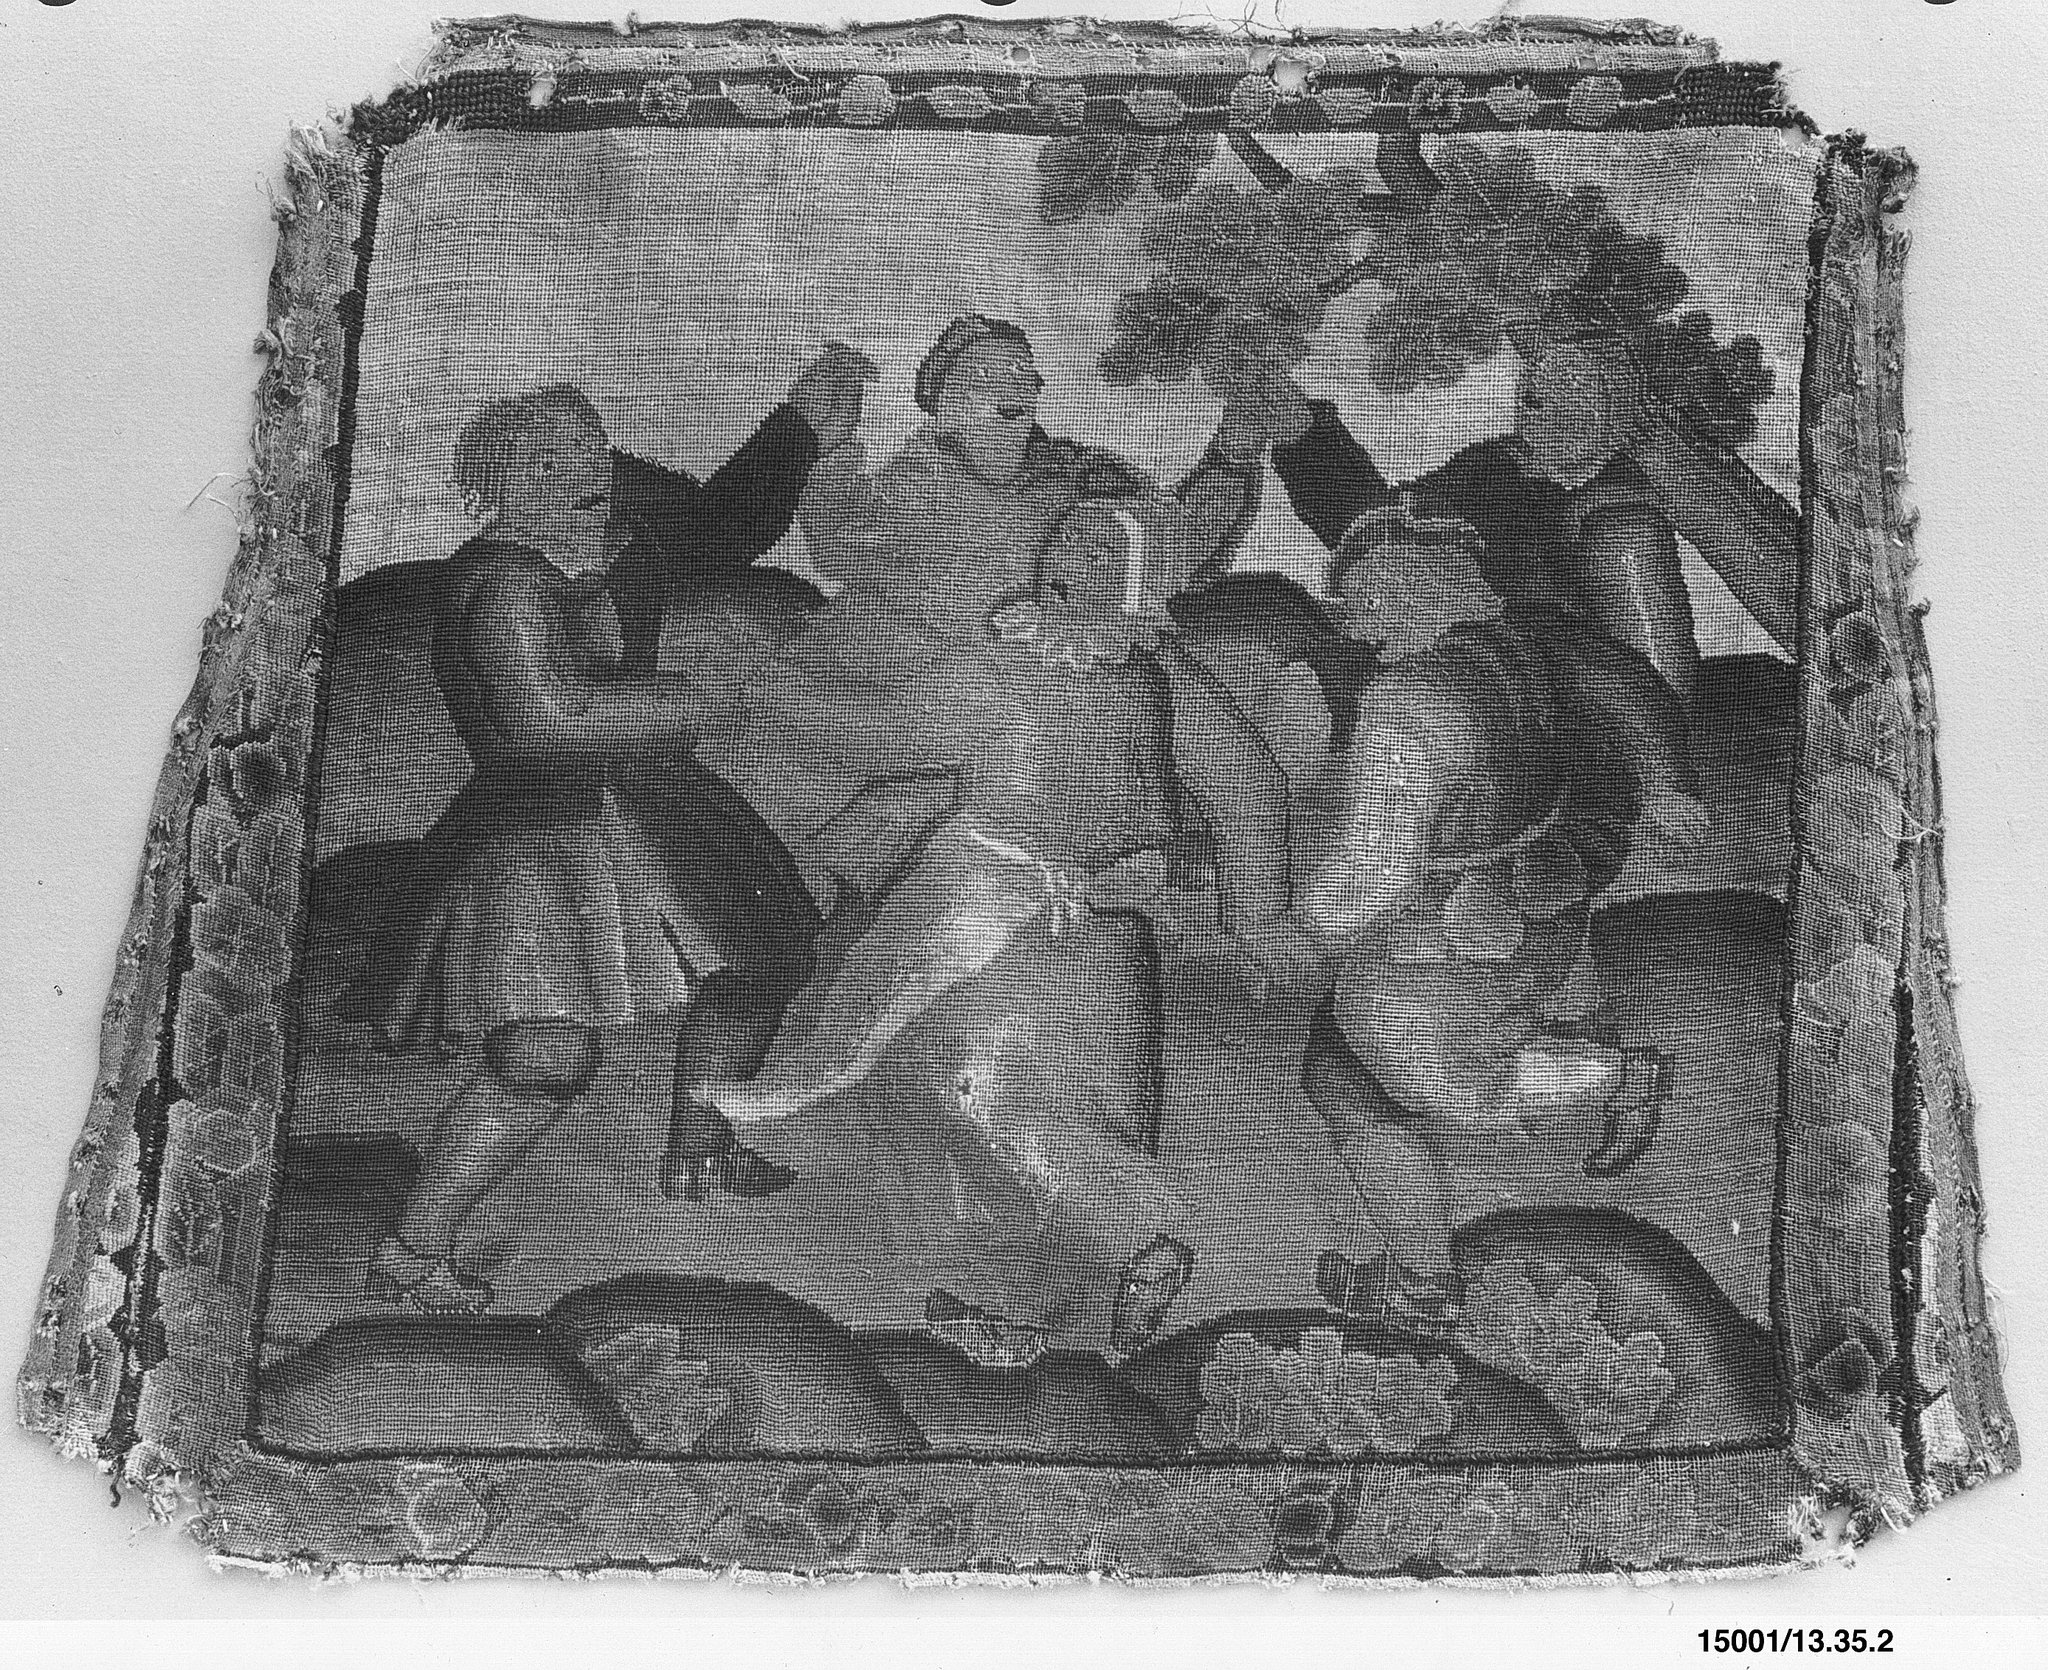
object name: cover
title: Chair seat cover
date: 1701-1800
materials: silk, wool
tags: men